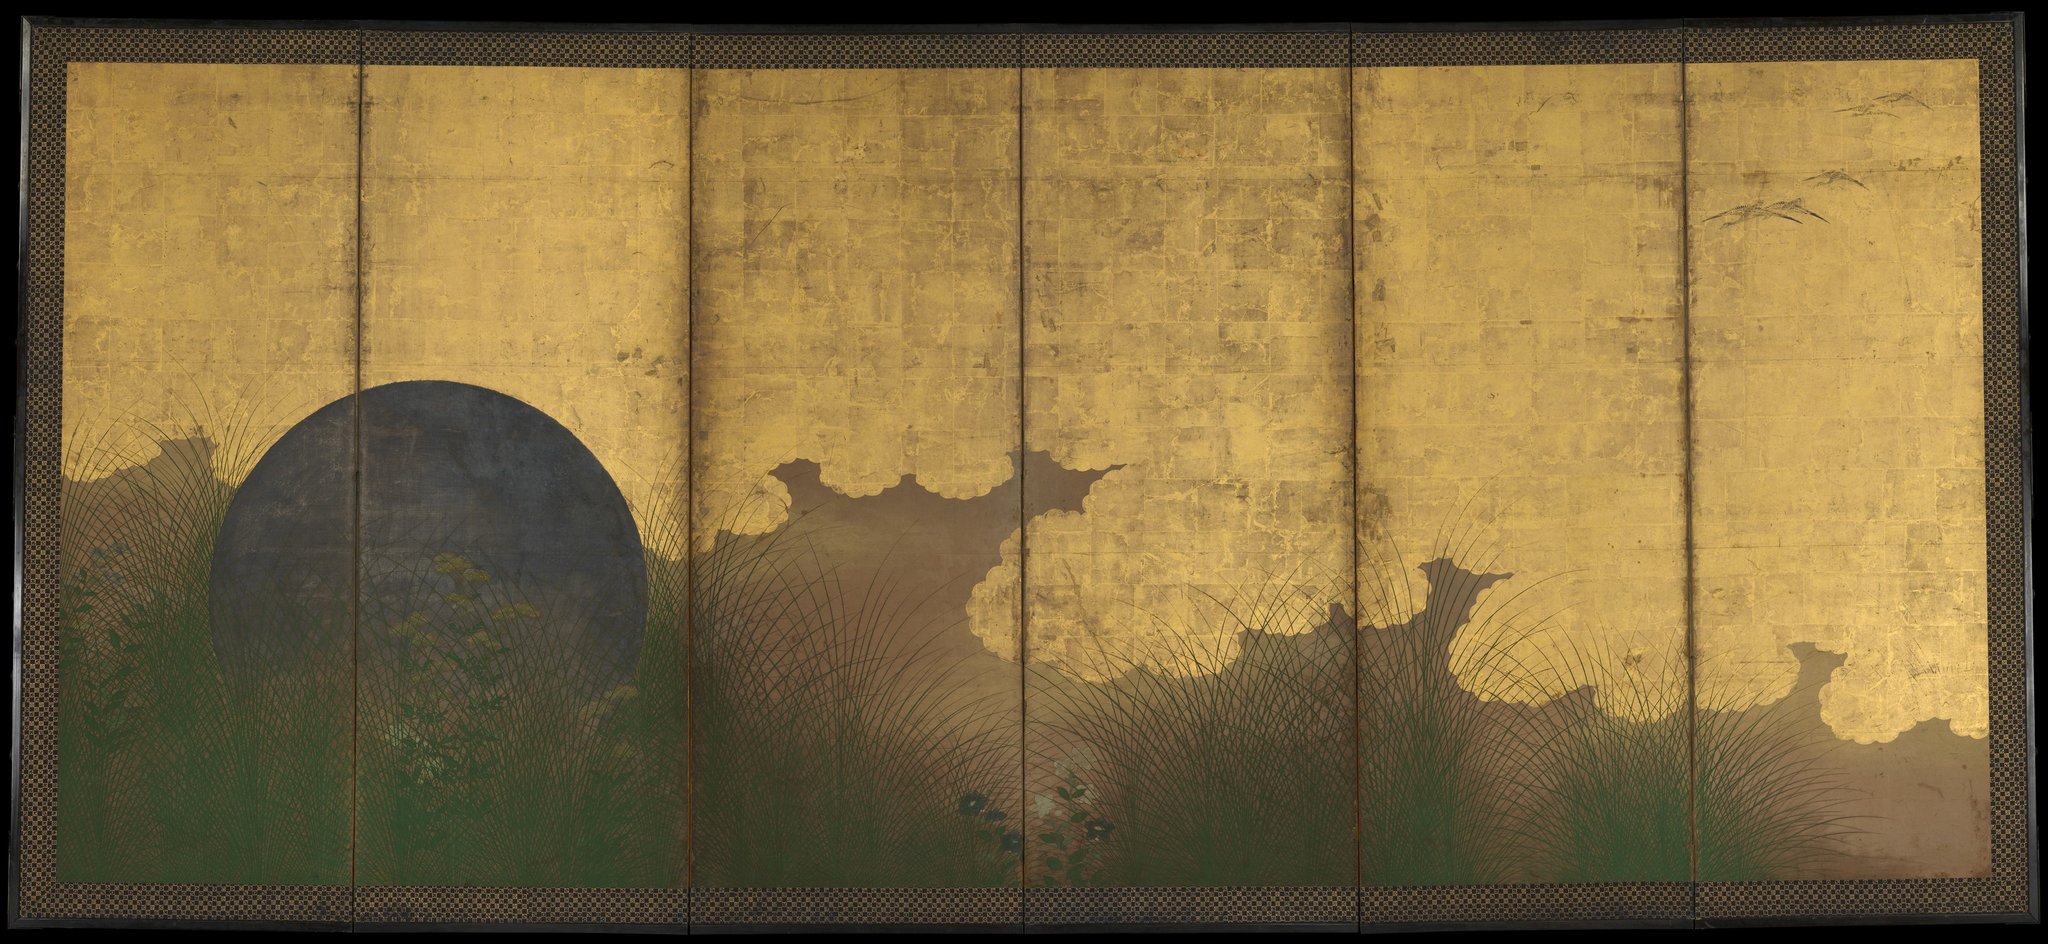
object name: screen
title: The Plains of Musashi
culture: japanese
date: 1601-1700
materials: gold, gold leaf, ink, panel, paper, silver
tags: moon